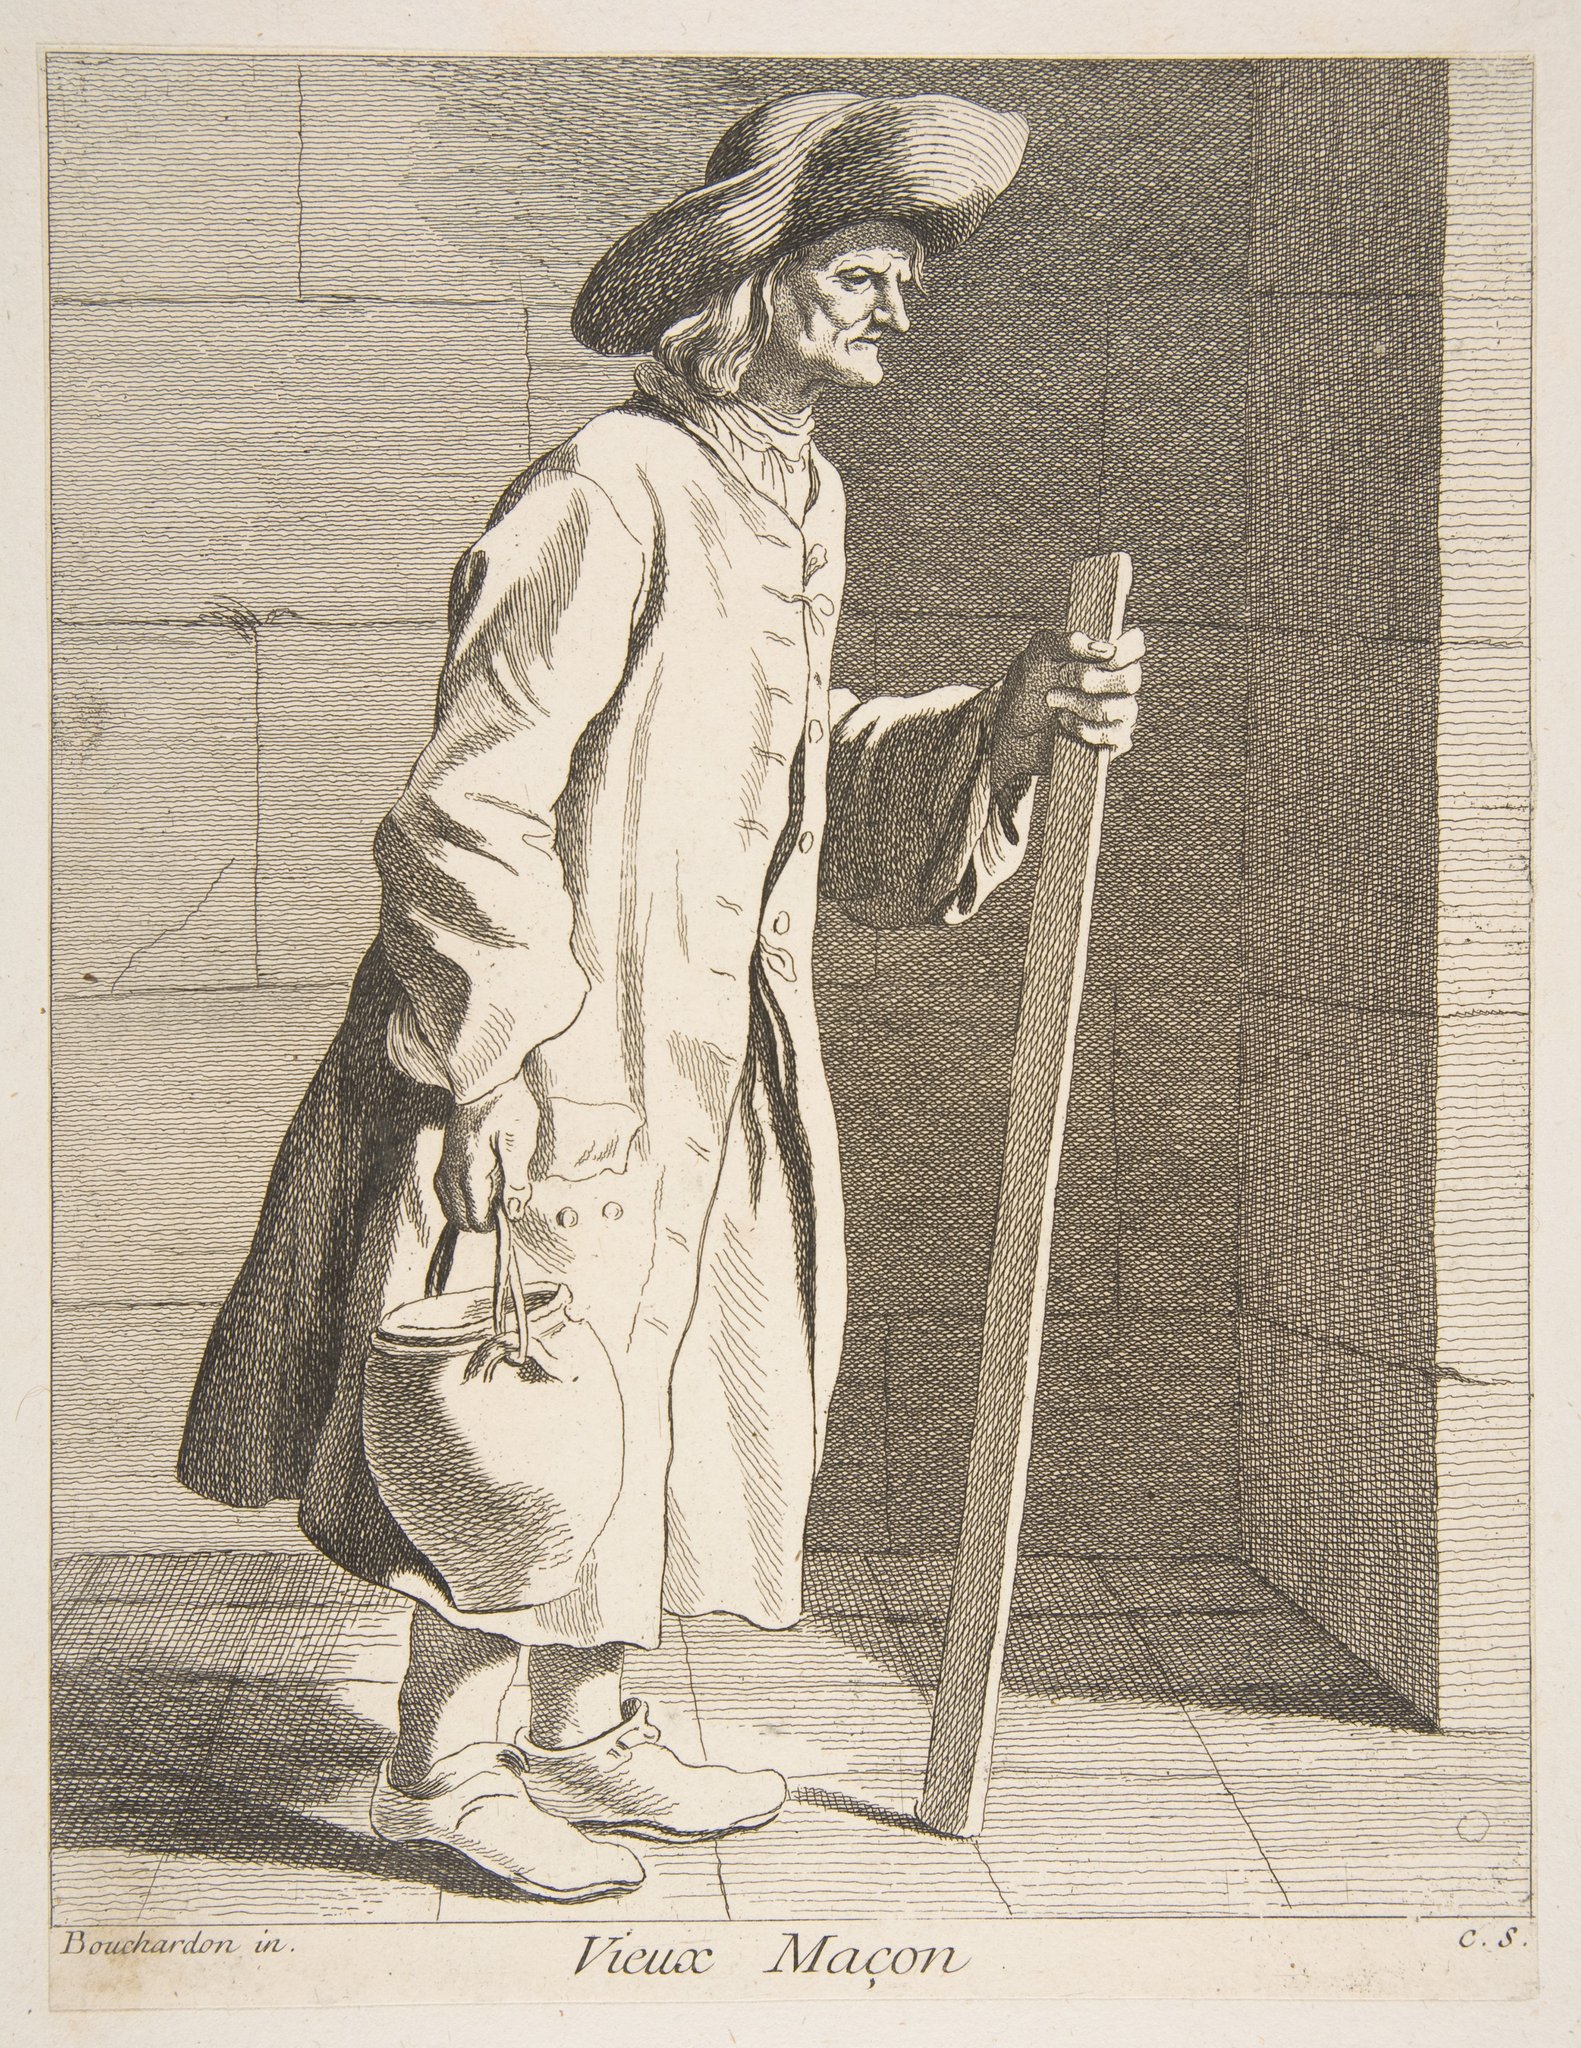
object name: print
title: Old Bricklayer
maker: anne claude philippe de tubières, comte de caylus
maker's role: artist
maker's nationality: french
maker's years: 1692-1765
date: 1737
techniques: engraving, etching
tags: men